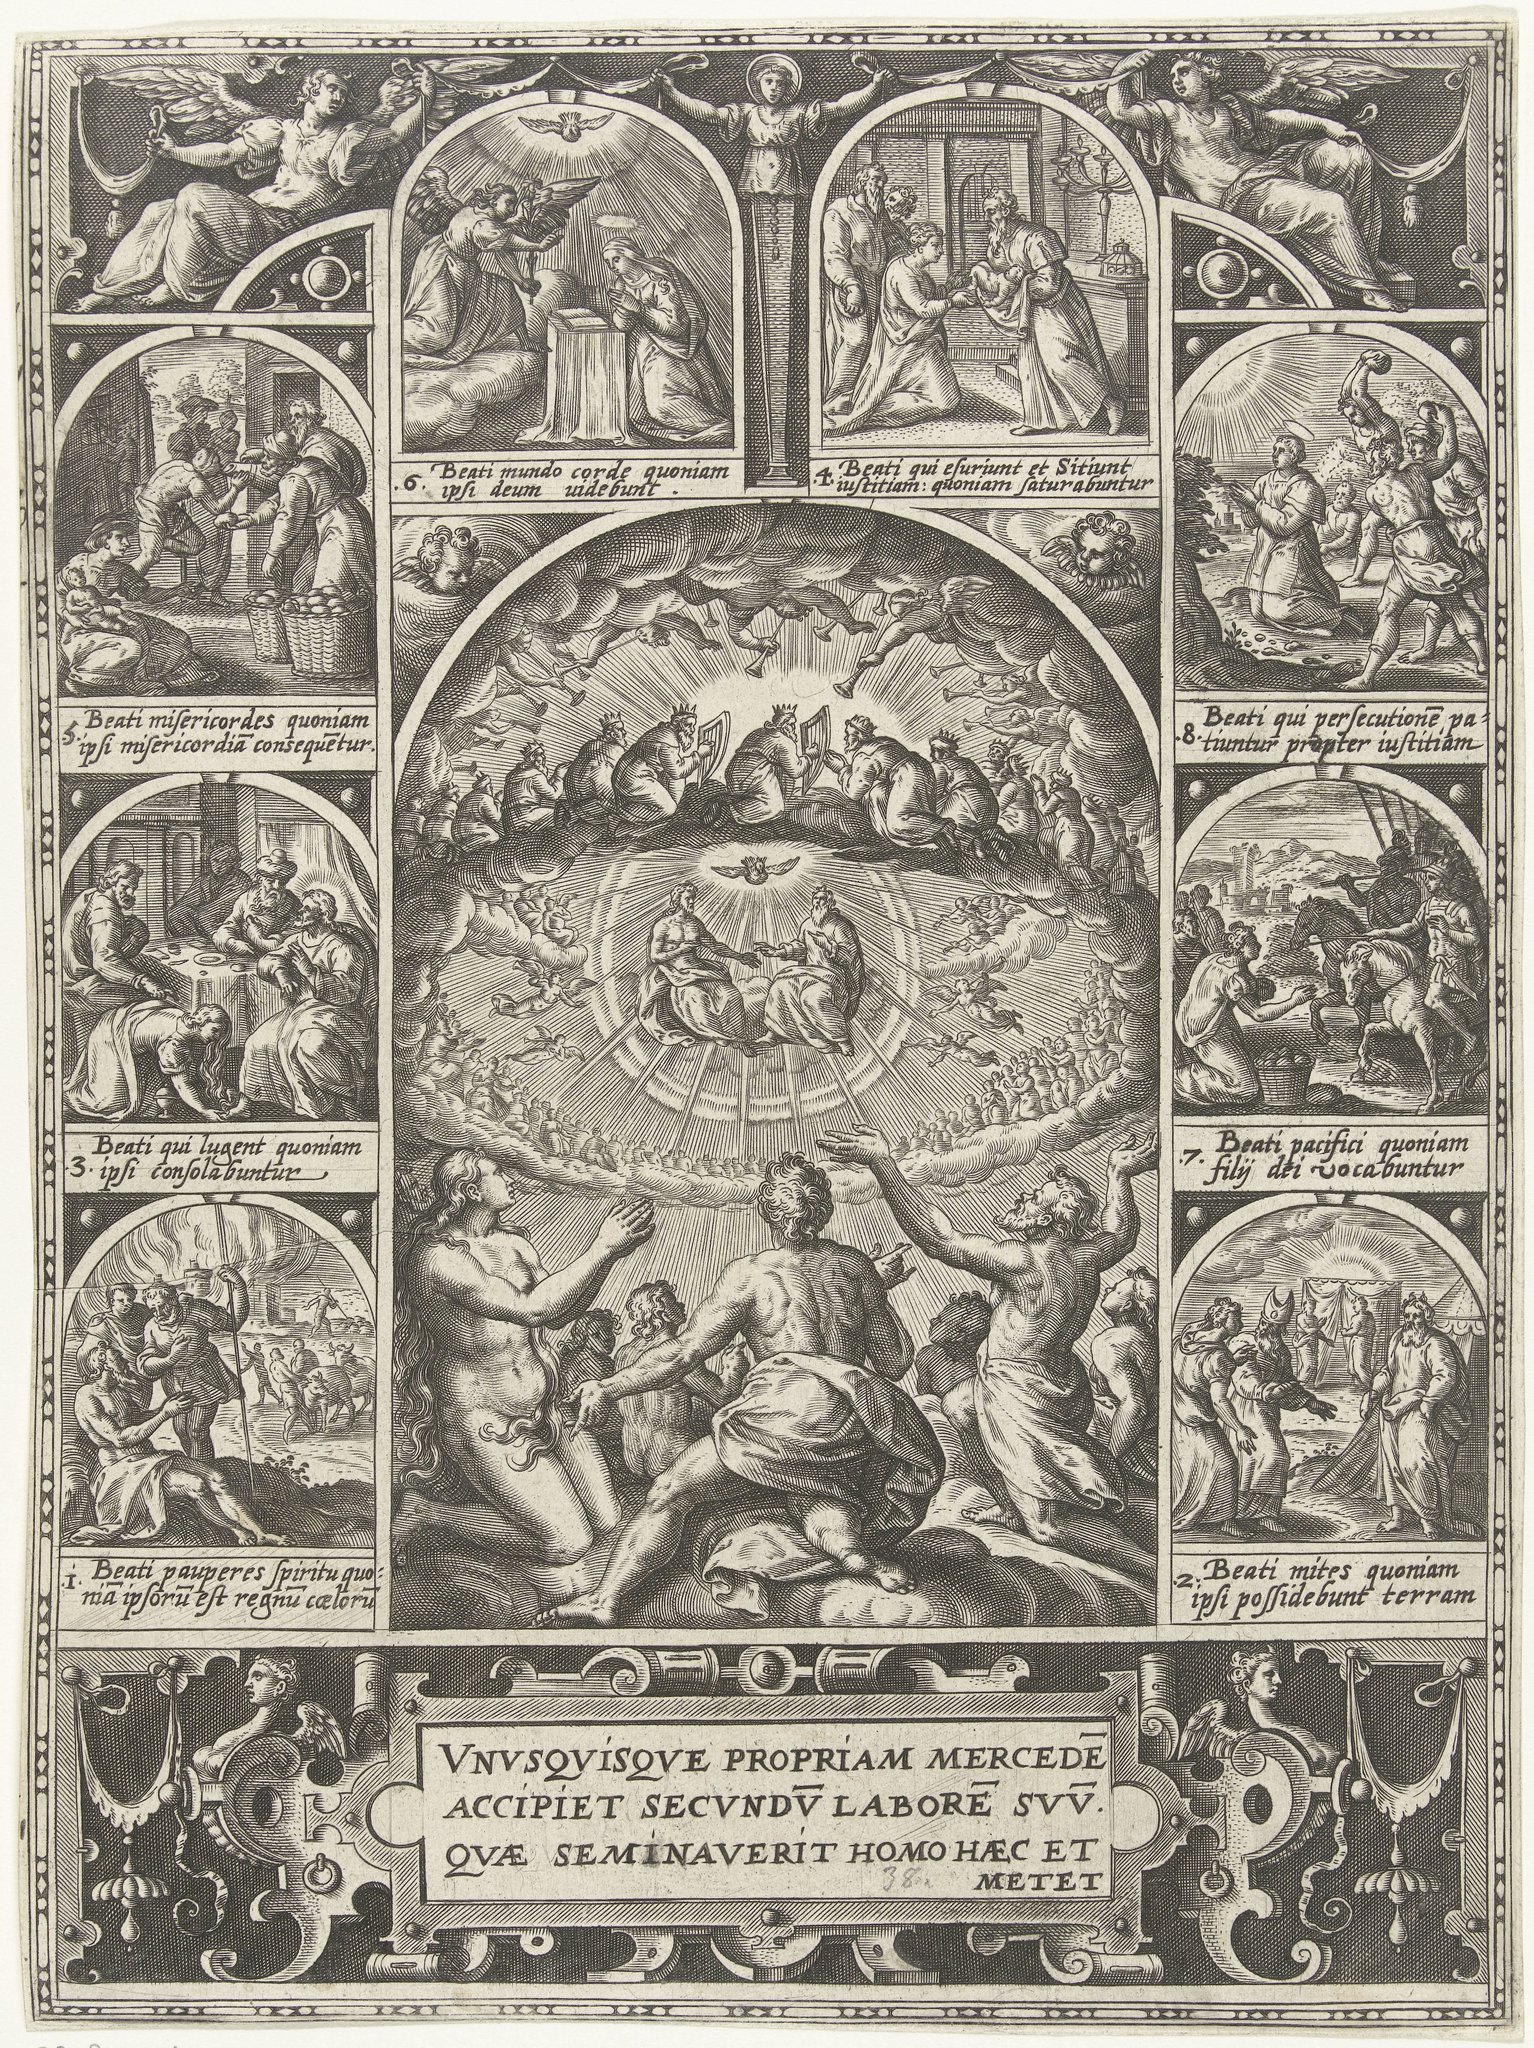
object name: print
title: De acht zaligsprekingen, de zeven daden van barmhartigheid, de zeven hoofdzonden en de keuze tussen Goed en Kwaad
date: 1554-1580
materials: paper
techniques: engraving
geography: antwerp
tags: beatitudes and blessings of christ, praise of the judgement of god in heaven, holy trinity in which one, two or all figures are represented in human shape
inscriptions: collector's mark: Lugt 2760, collector's mark: Lugt 2228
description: Centraal aanbidden de hemelse heerscharen in de wolken en de mensen op aarde de Drieëenheid. Rond deze voorstelling acht kleine scènes waarin de acht zaligheden zijn afgebeeld. Middenonder in cartouche een Latijnse tekst. De prent maakt deel uit van een serie over de enkele centrale stellingen van het geloof.